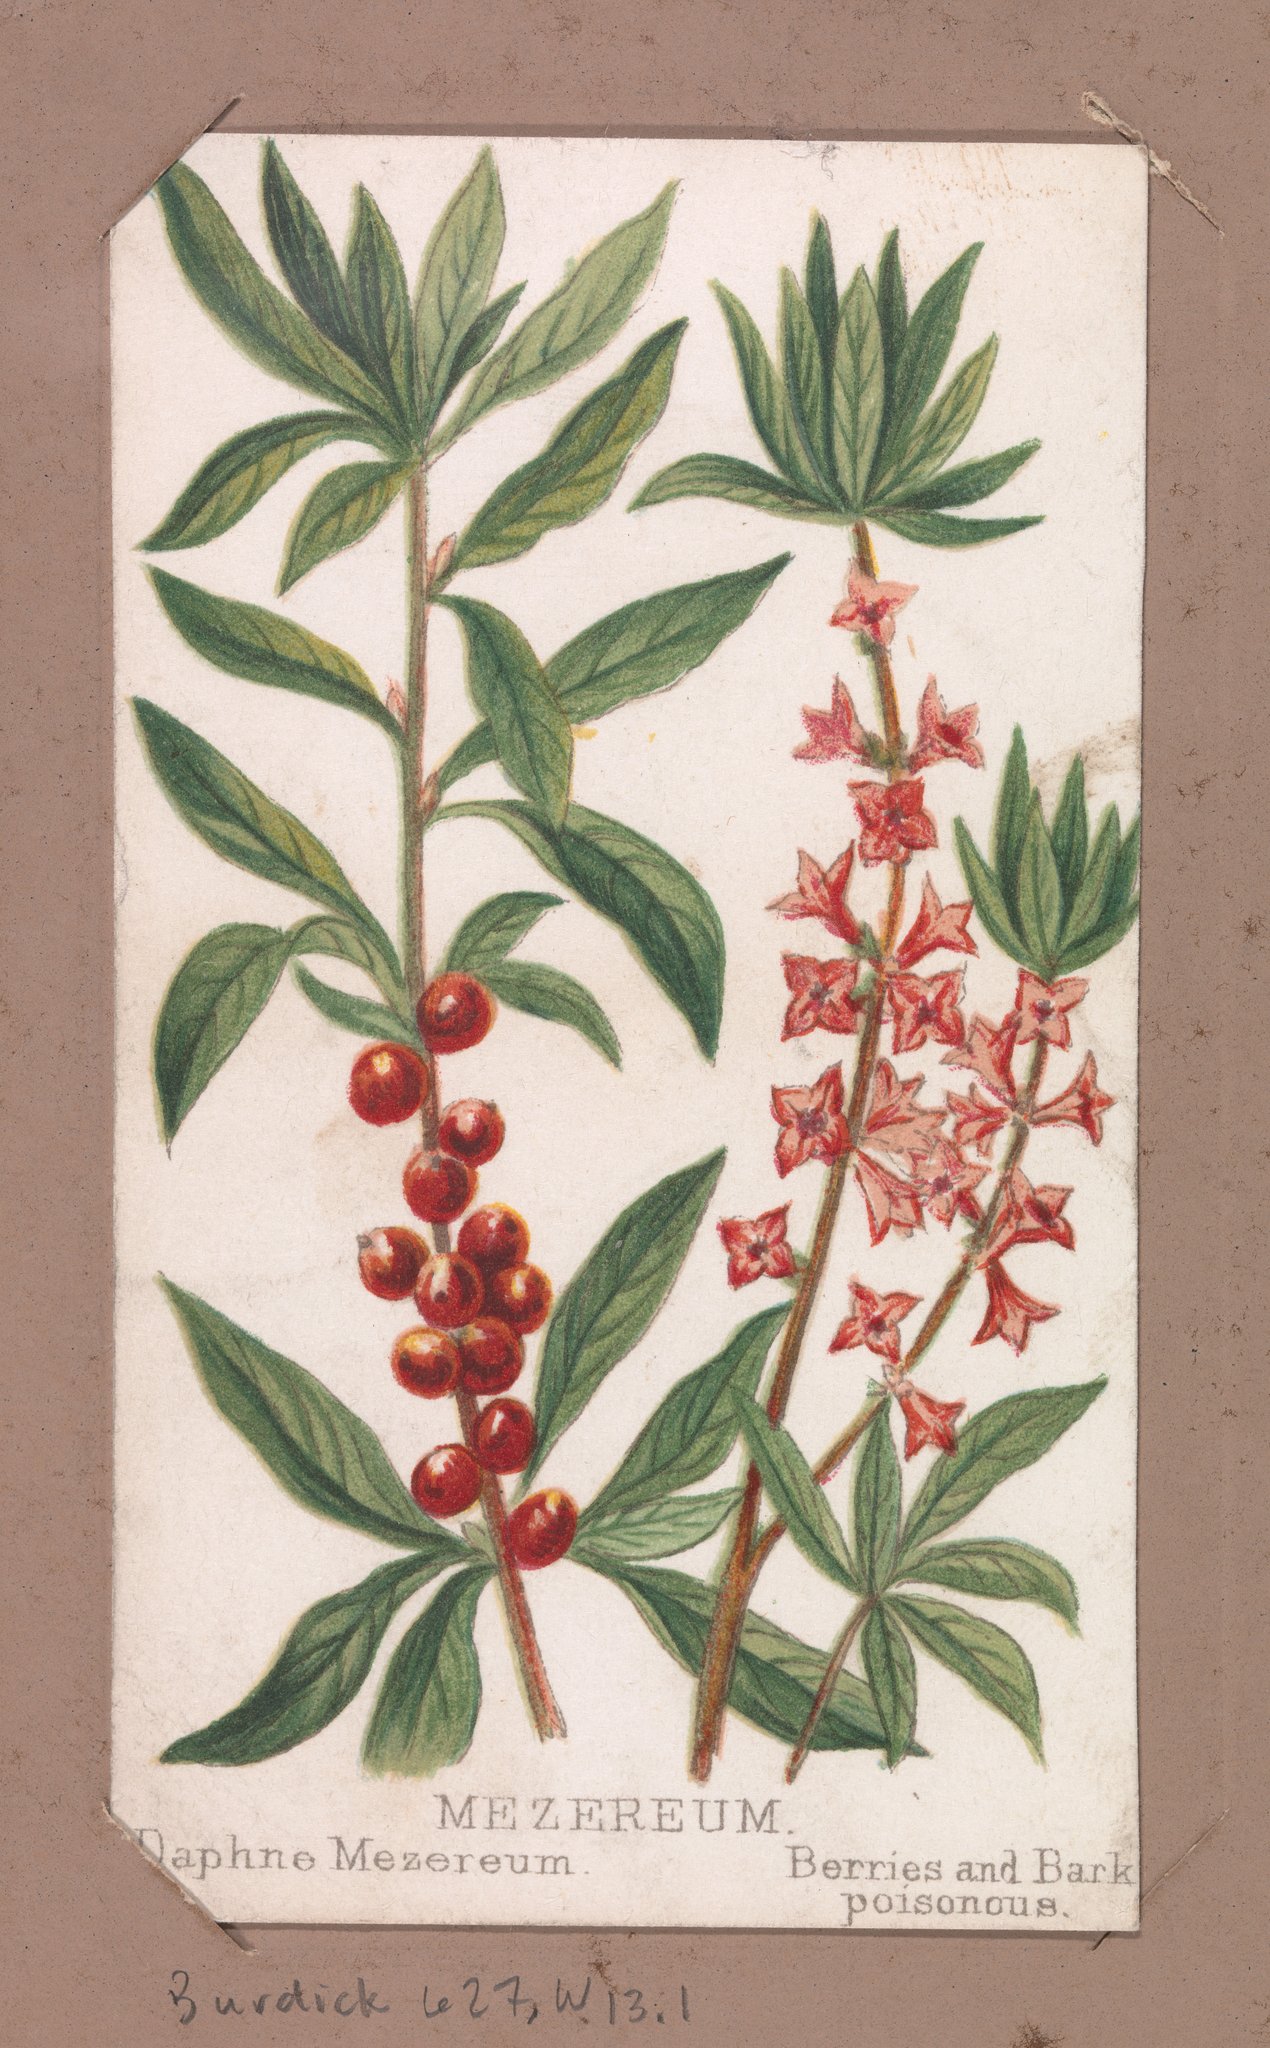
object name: album card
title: Mezereum from the Plants series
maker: louis prang & co.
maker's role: publisher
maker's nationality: american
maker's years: 1800-1950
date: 1862-1869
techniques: lithograph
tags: plants